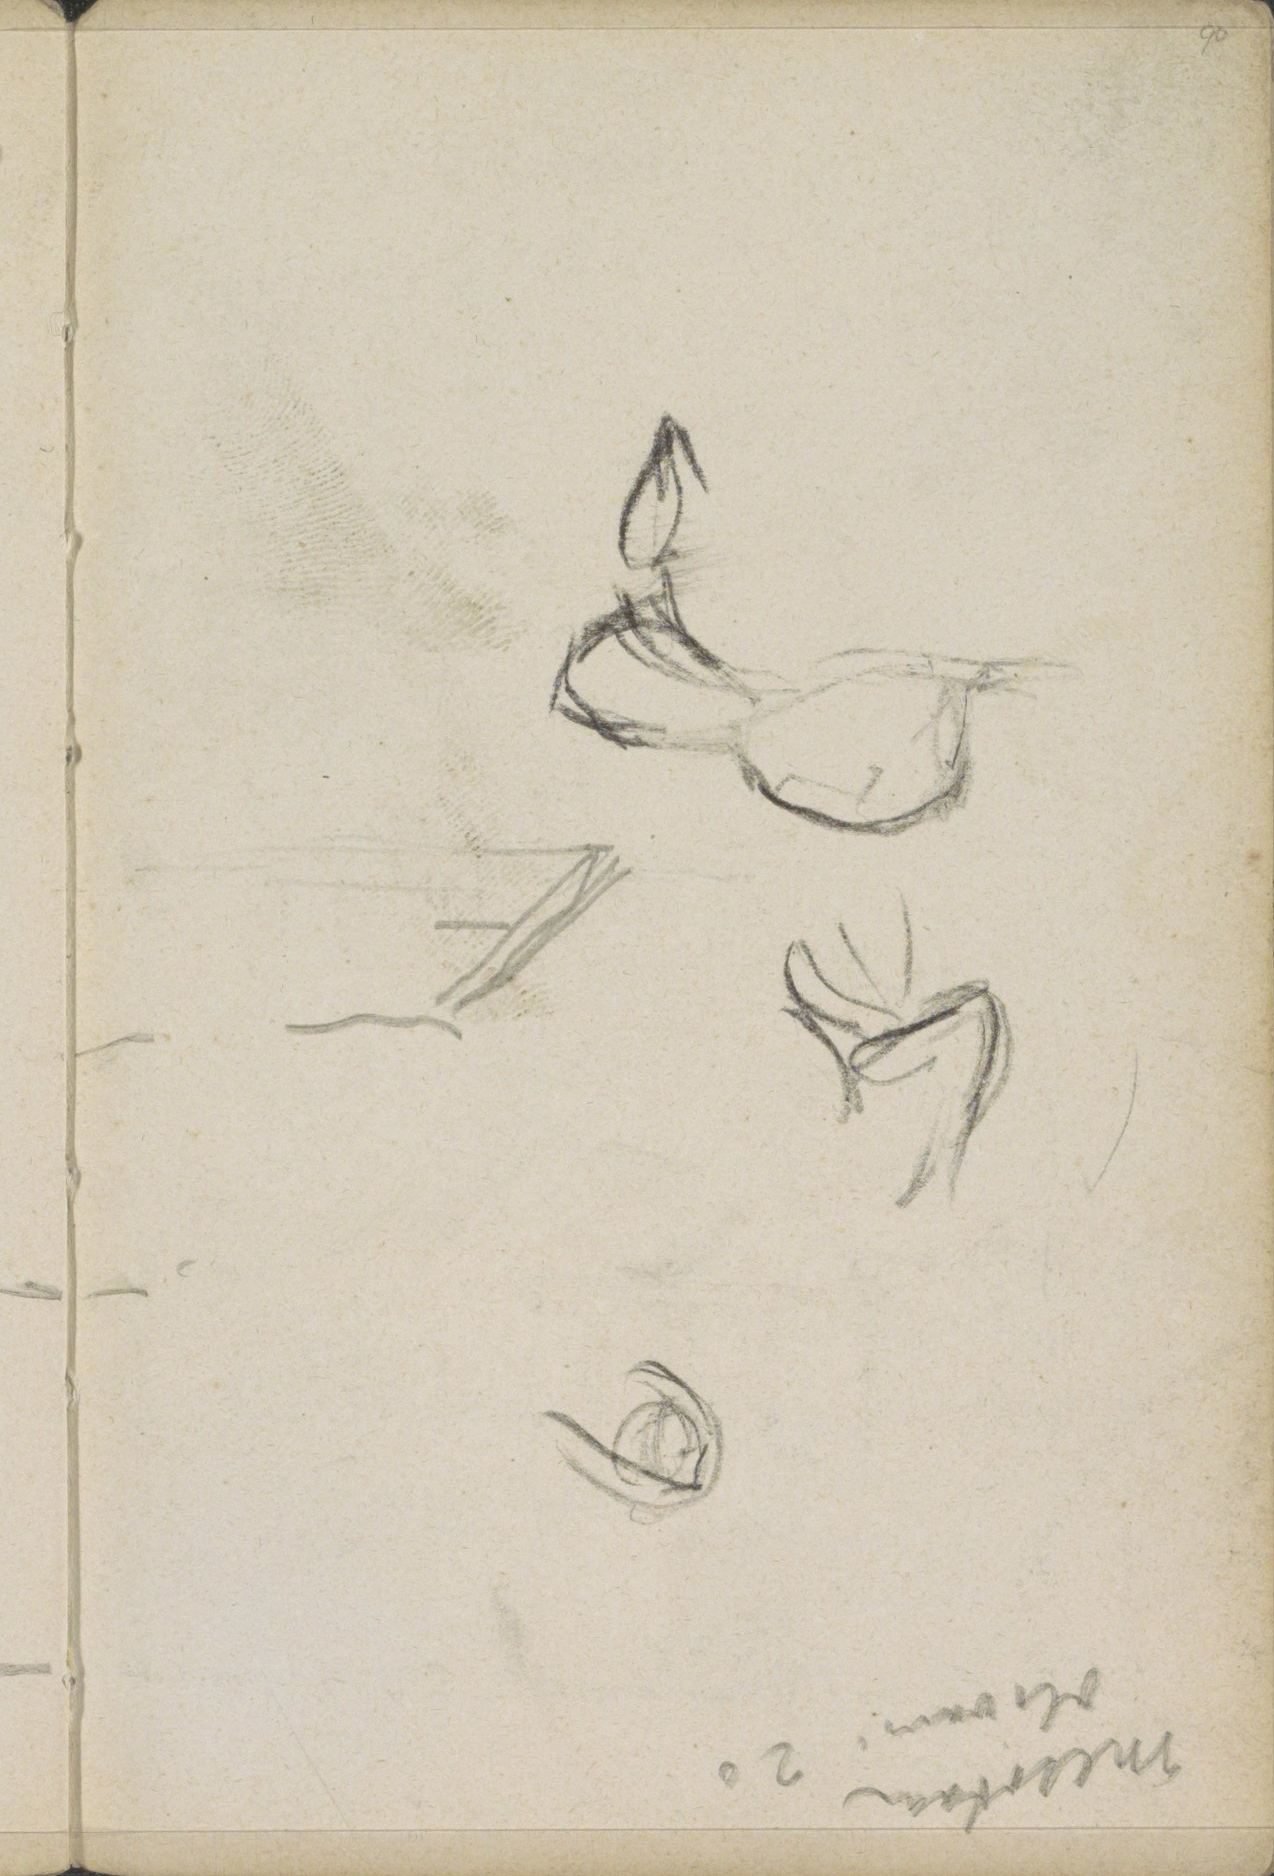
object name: sketchbook leaf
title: Studieblad met een oog, een neus en een hoed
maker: george hendrik breitner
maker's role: draughtsman, painter, print maker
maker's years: 1857-1923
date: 1886-1908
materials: chalk, paper, pencil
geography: amsterdam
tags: head-gear: hat, eyes, parts of the face: nose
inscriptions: annotation: ‘[...]’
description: Pagina 90 uit een schetsboek met 46 bladen vervaardigd te Amsterdam, Haarlem en Antwerpen.